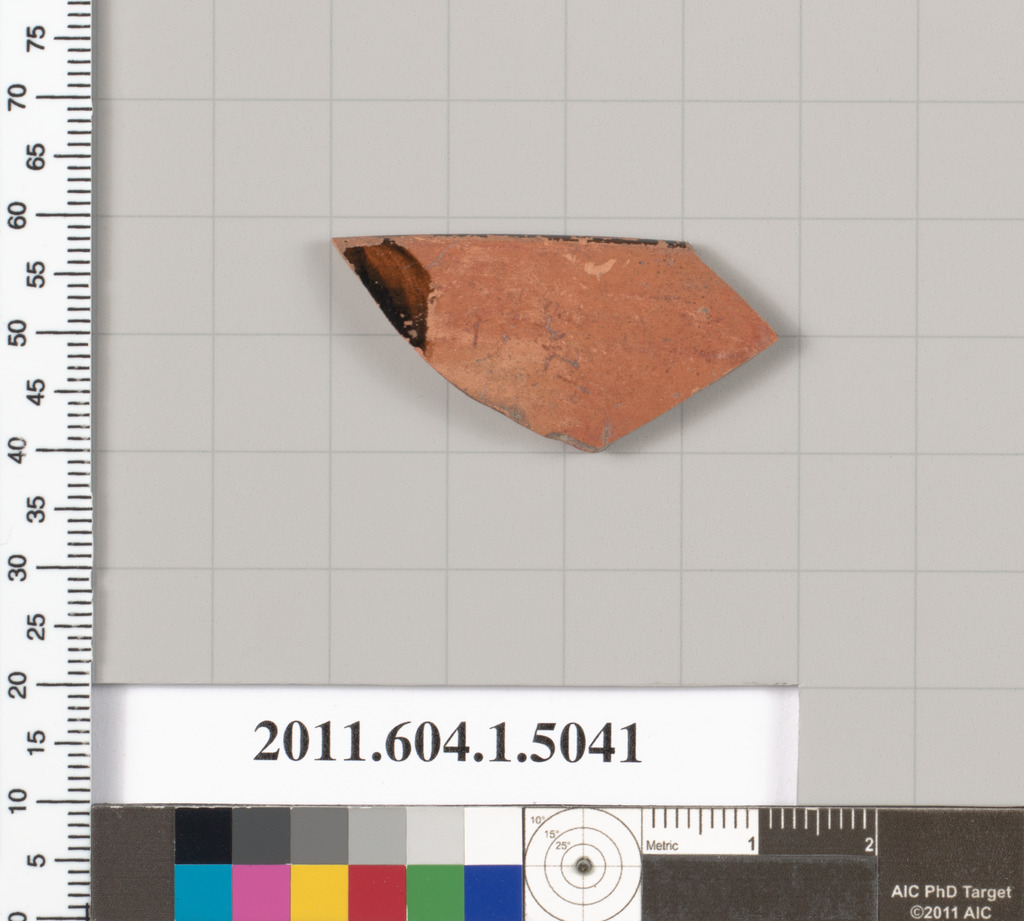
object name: kylix fragment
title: Terracotta fragment of a kylix (drinking cup)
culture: greek, attic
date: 500-470 BCE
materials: terracotta